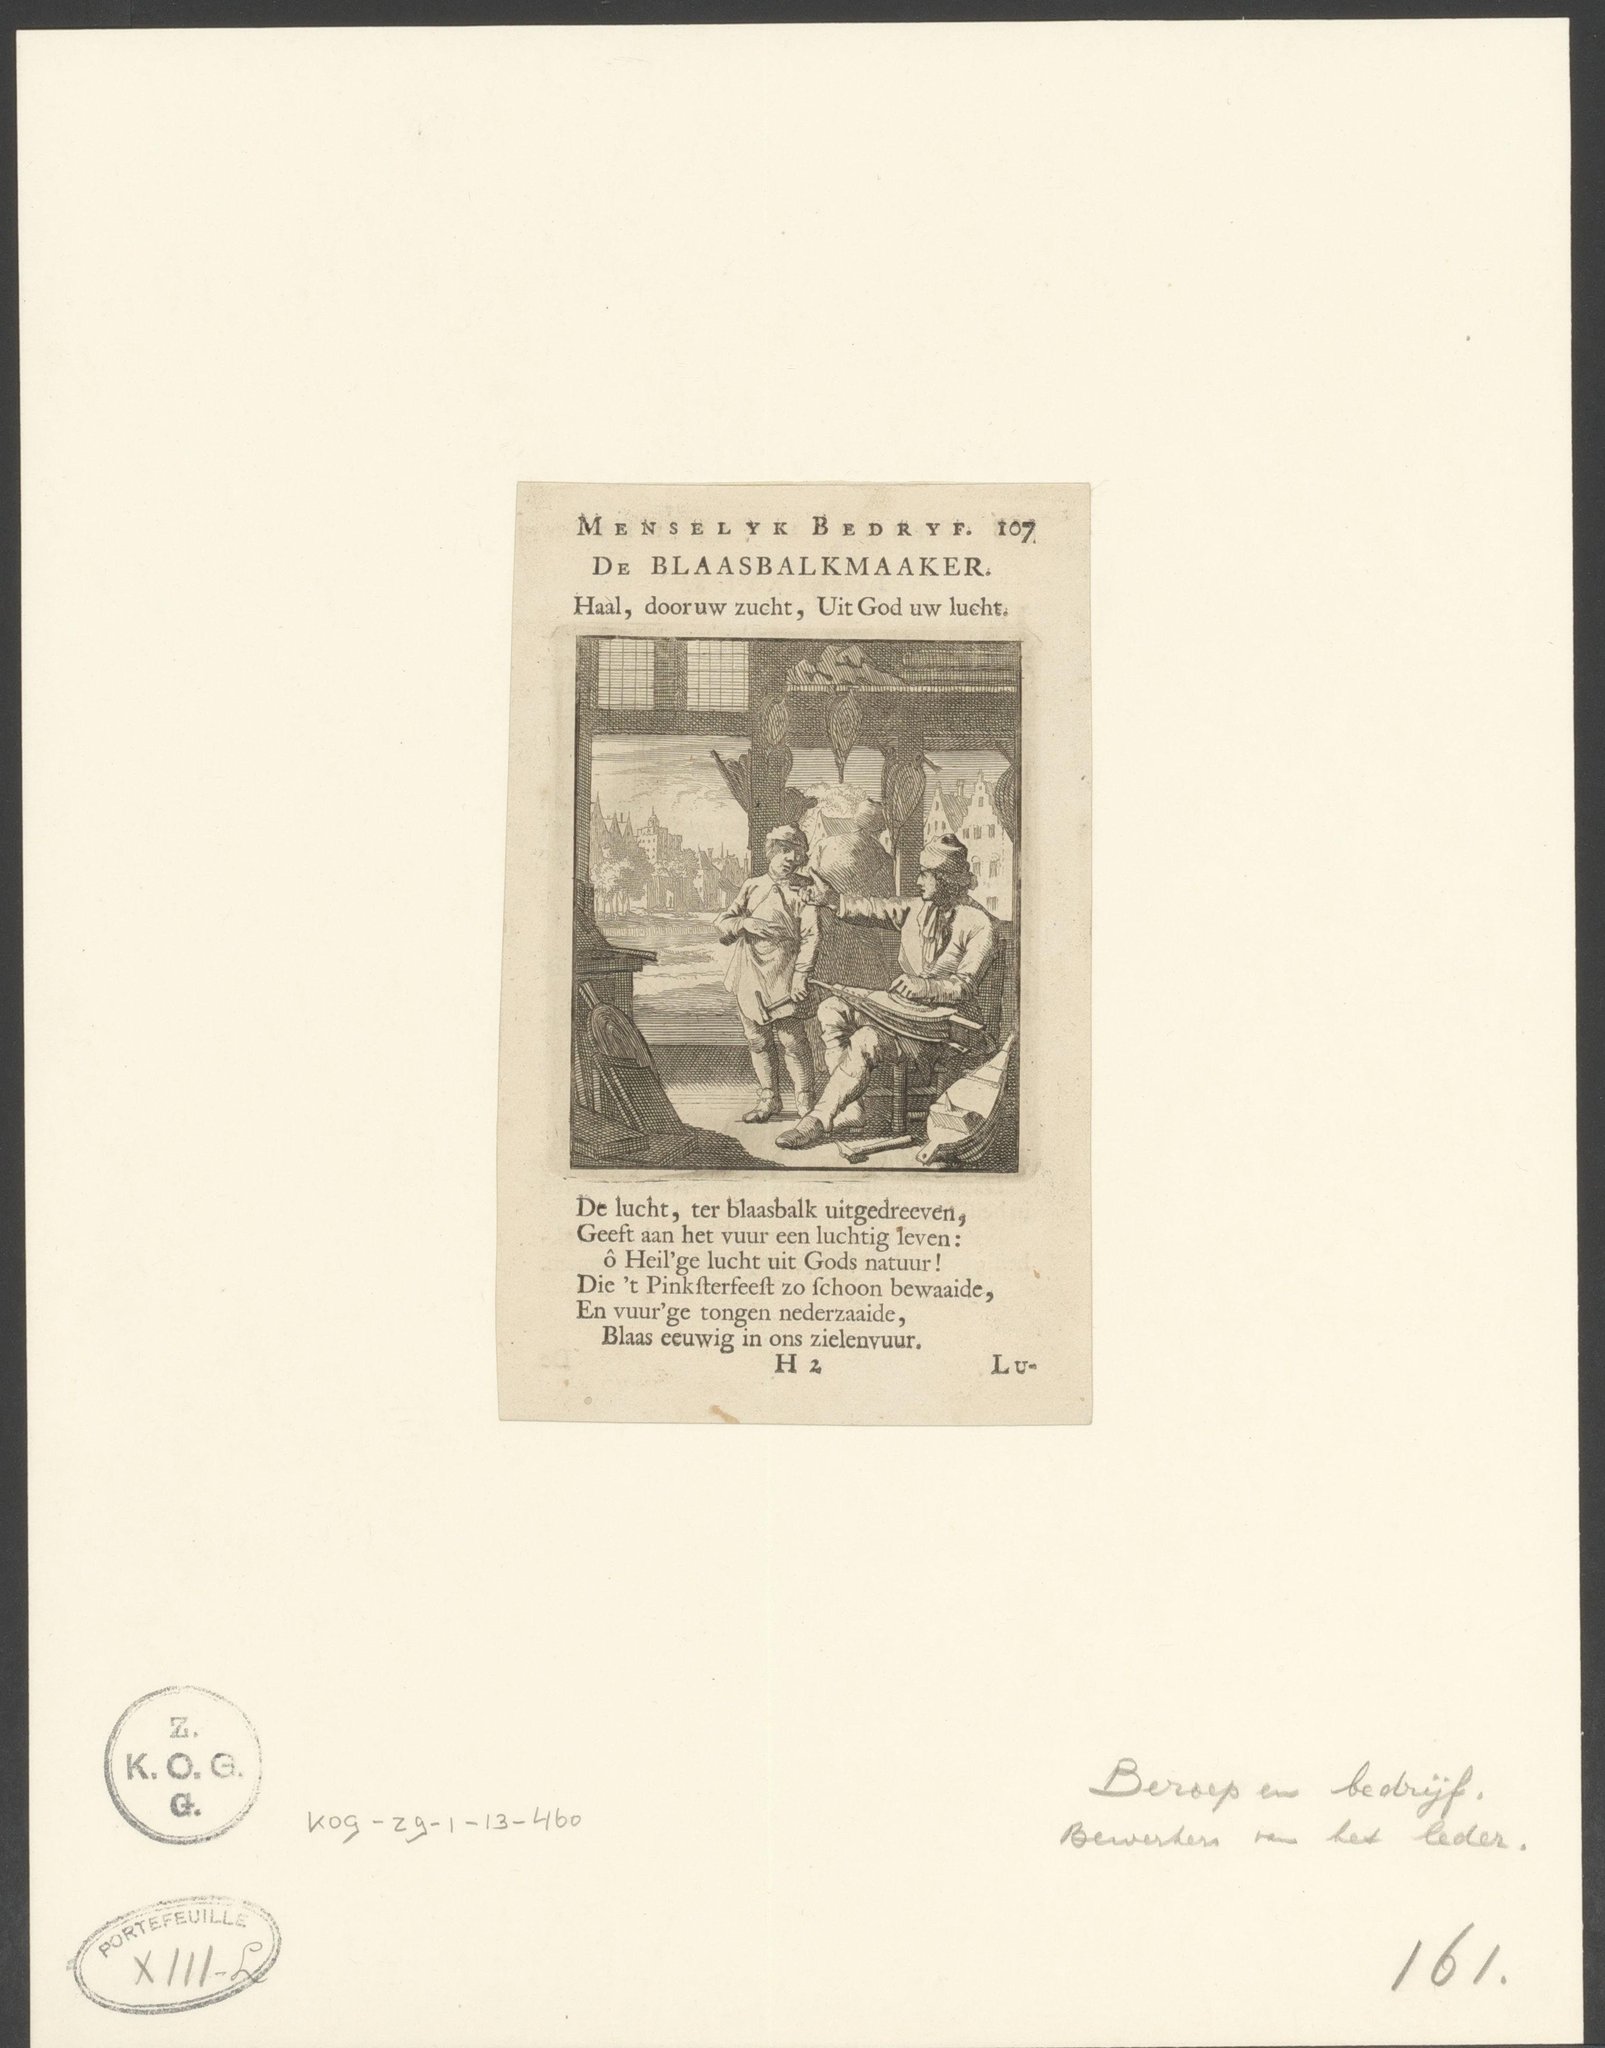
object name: book illustration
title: Blaasbalgmaker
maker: cornelis van der sys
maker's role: publisher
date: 1718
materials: paper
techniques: etching, letterpress printing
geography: amsterdam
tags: handicrafts, craftsman at work, bellows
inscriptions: collector's mark: Lugt 1641, stamp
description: Prent oorspronkelijk verschenen in de 100-delige serie beroepsprenten van Jan en Caspar Luyken, getiteld: Het menselyk bedryf. S.l.s.n., 1694 (eerste druk). Daarna is de titel en het vers afgesneden. De prenten in diverse publicaties verschenen en gekopieerd. Huidige staat uit: Luyken, Jan en Caspar. Spiegel van het menselyk bedryf (...). Amsterdam: Cornelis van der Sys, 1718, p. 107. Prent waarschijnlijk ook gebruikt in eerdere (1704) en latere (1730, 1749, 1767) publicaties.